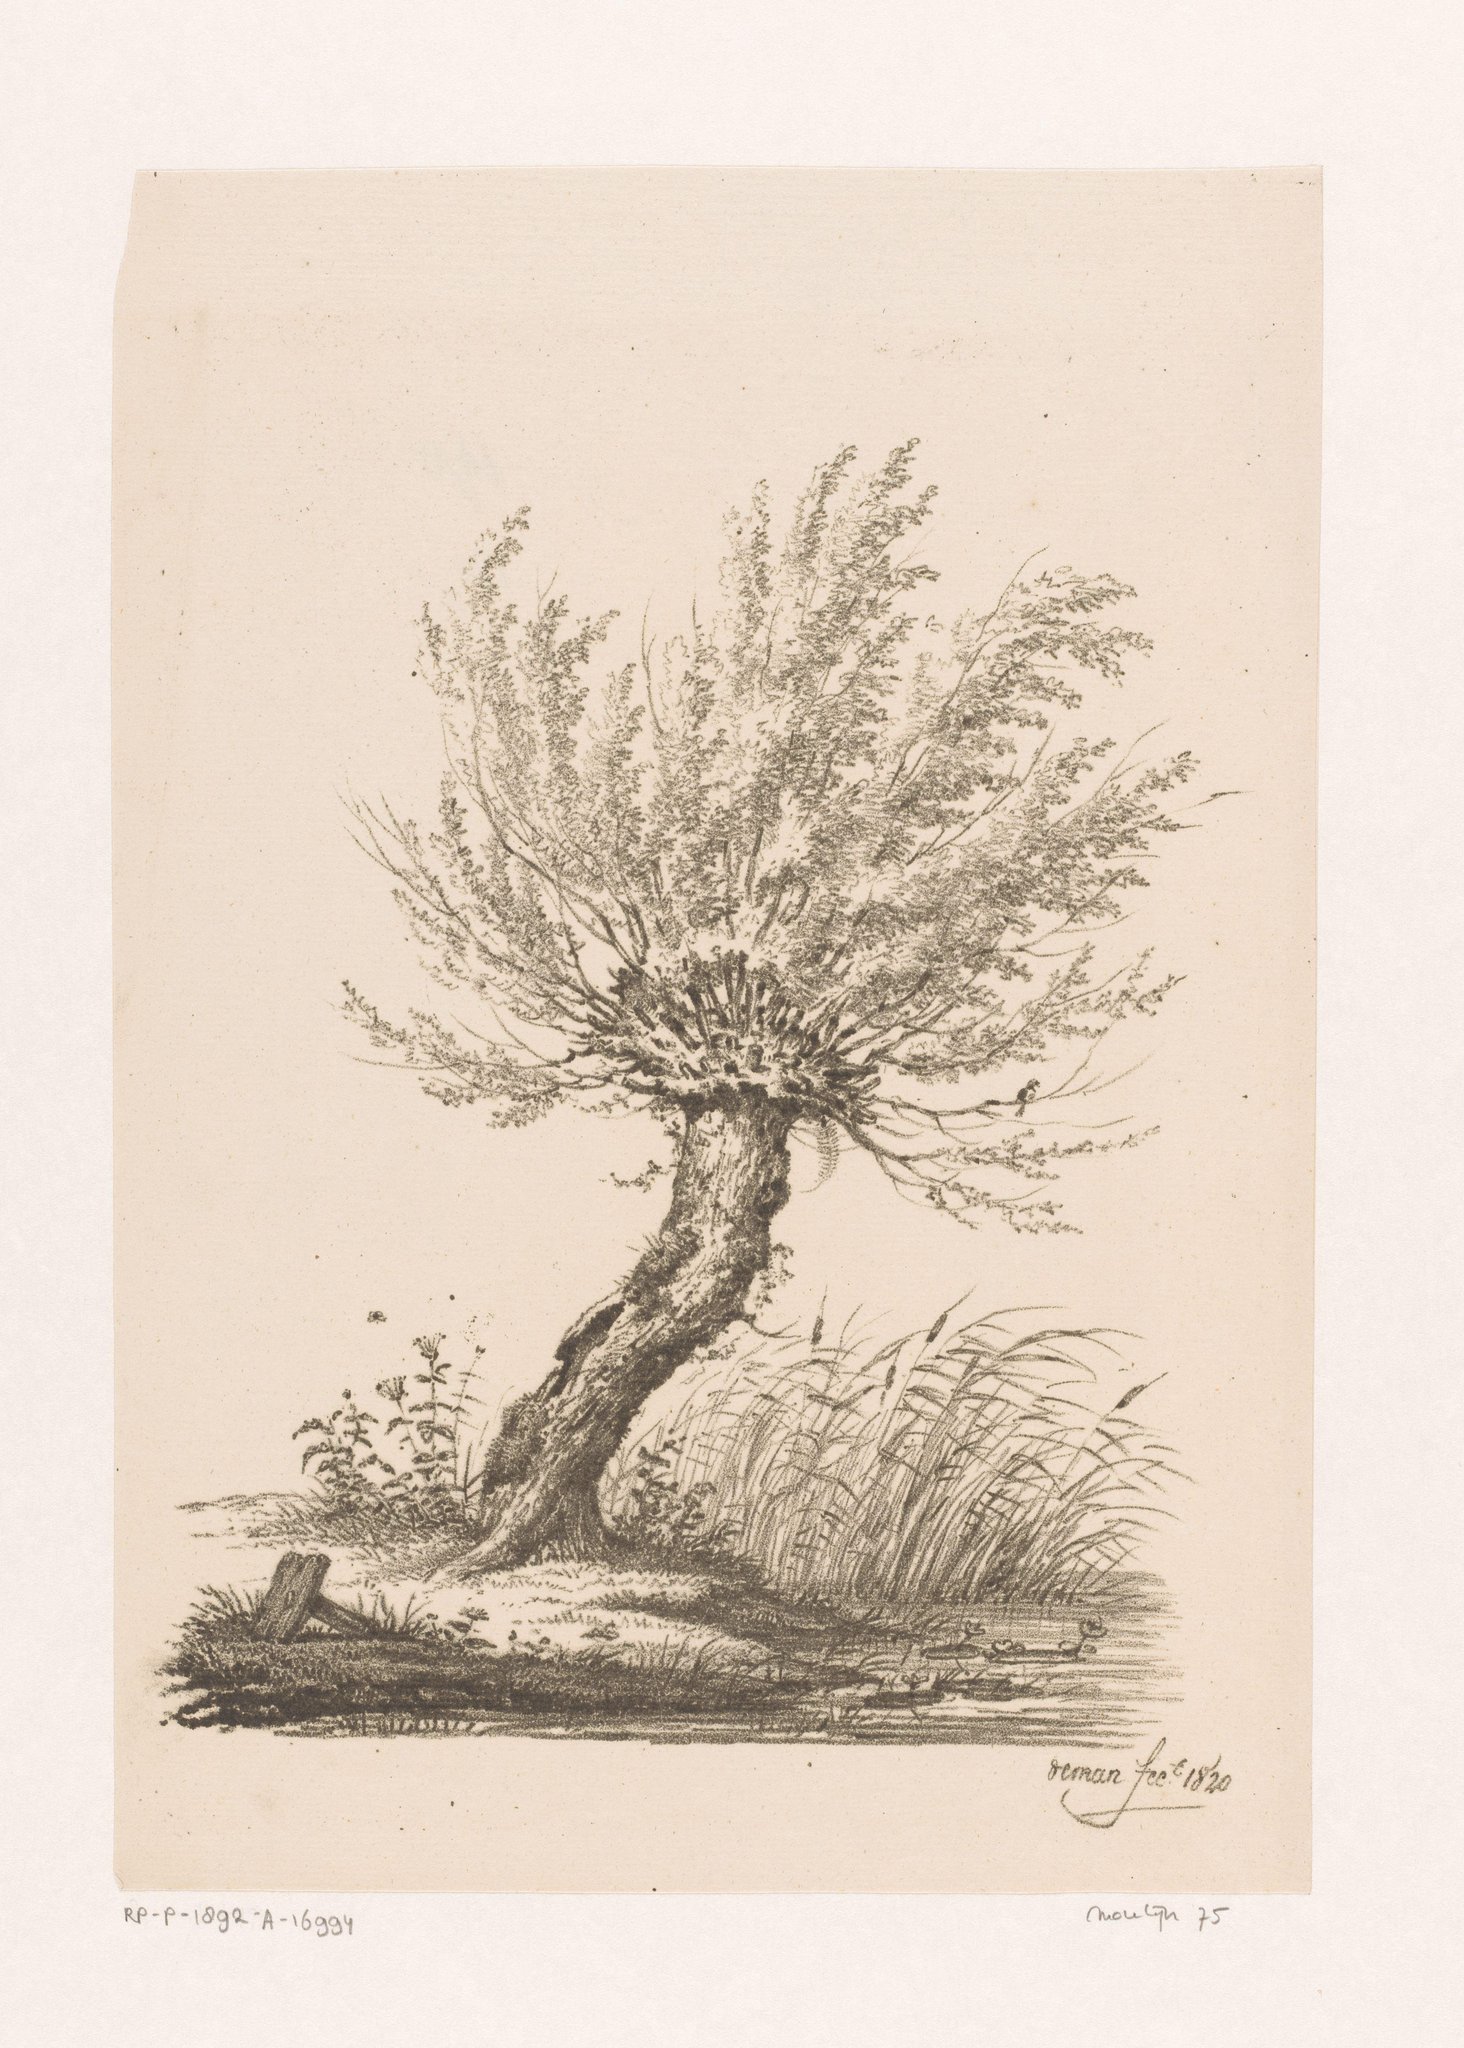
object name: print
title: Knotwilg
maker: anthonie willem hendrik nolthenius de man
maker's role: draughtsman, print maker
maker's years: 1793-1842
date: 1820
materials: paper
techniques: lithograph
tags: plants and herbs: reed, trees: willow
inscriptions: collector's mark: Lugt 2228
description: De boom staat aan een waterkant met riet.